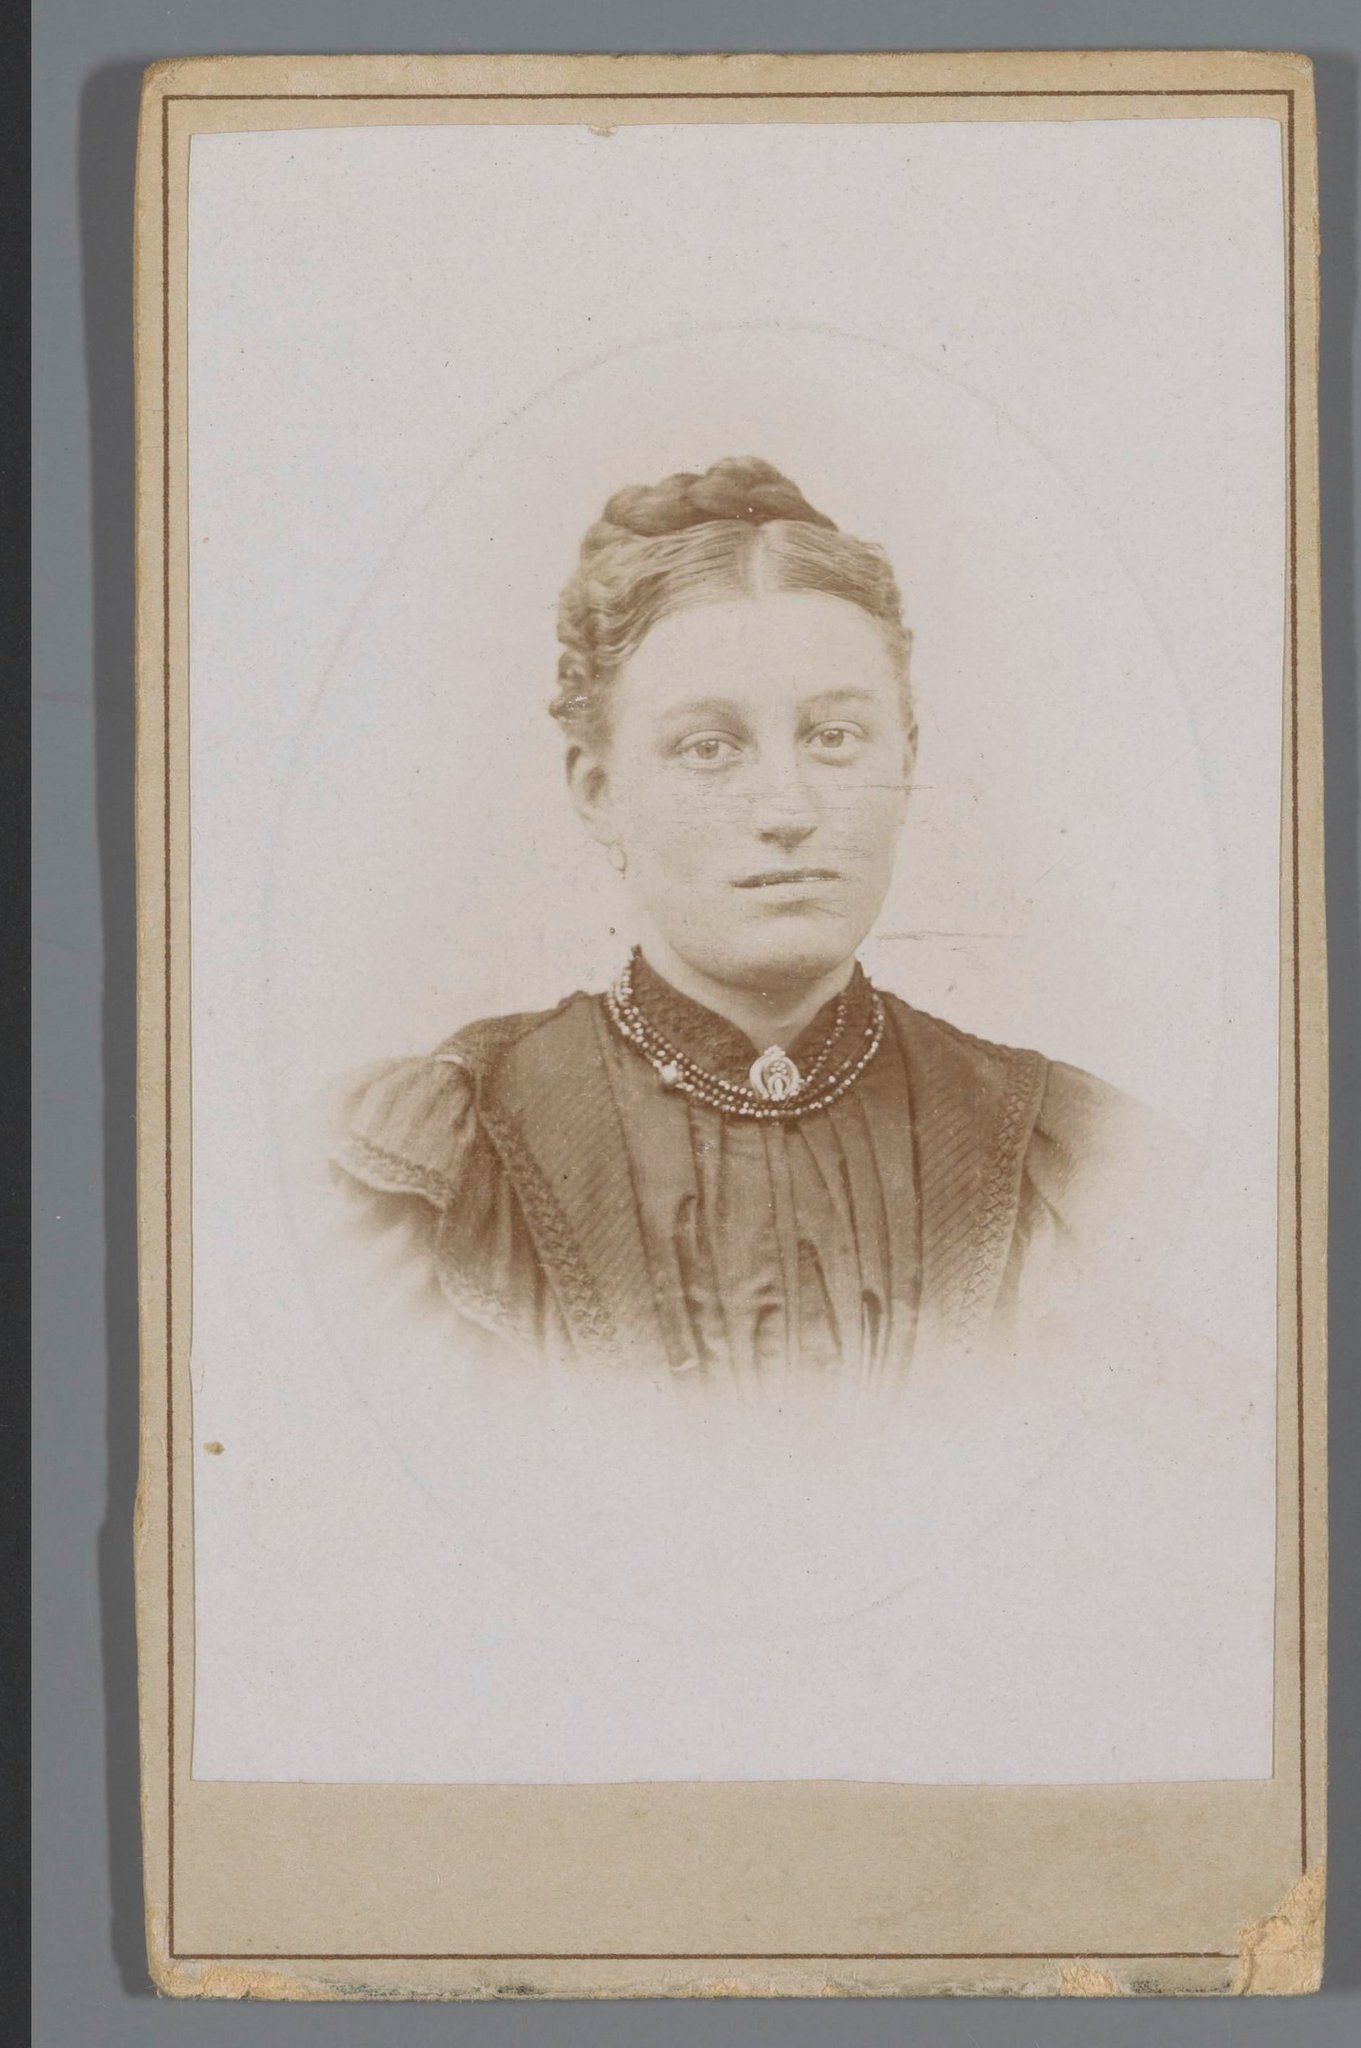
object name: semi enamel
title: Portret van Neeltje Buurs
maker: Anonymous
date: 1880-1920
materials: cardboard, celluloid, photographic support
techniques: gelatin silver print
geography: netherlands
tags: historical persons - bb - woman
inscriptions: inscription: ‘Neeltje Buurs A.d.’